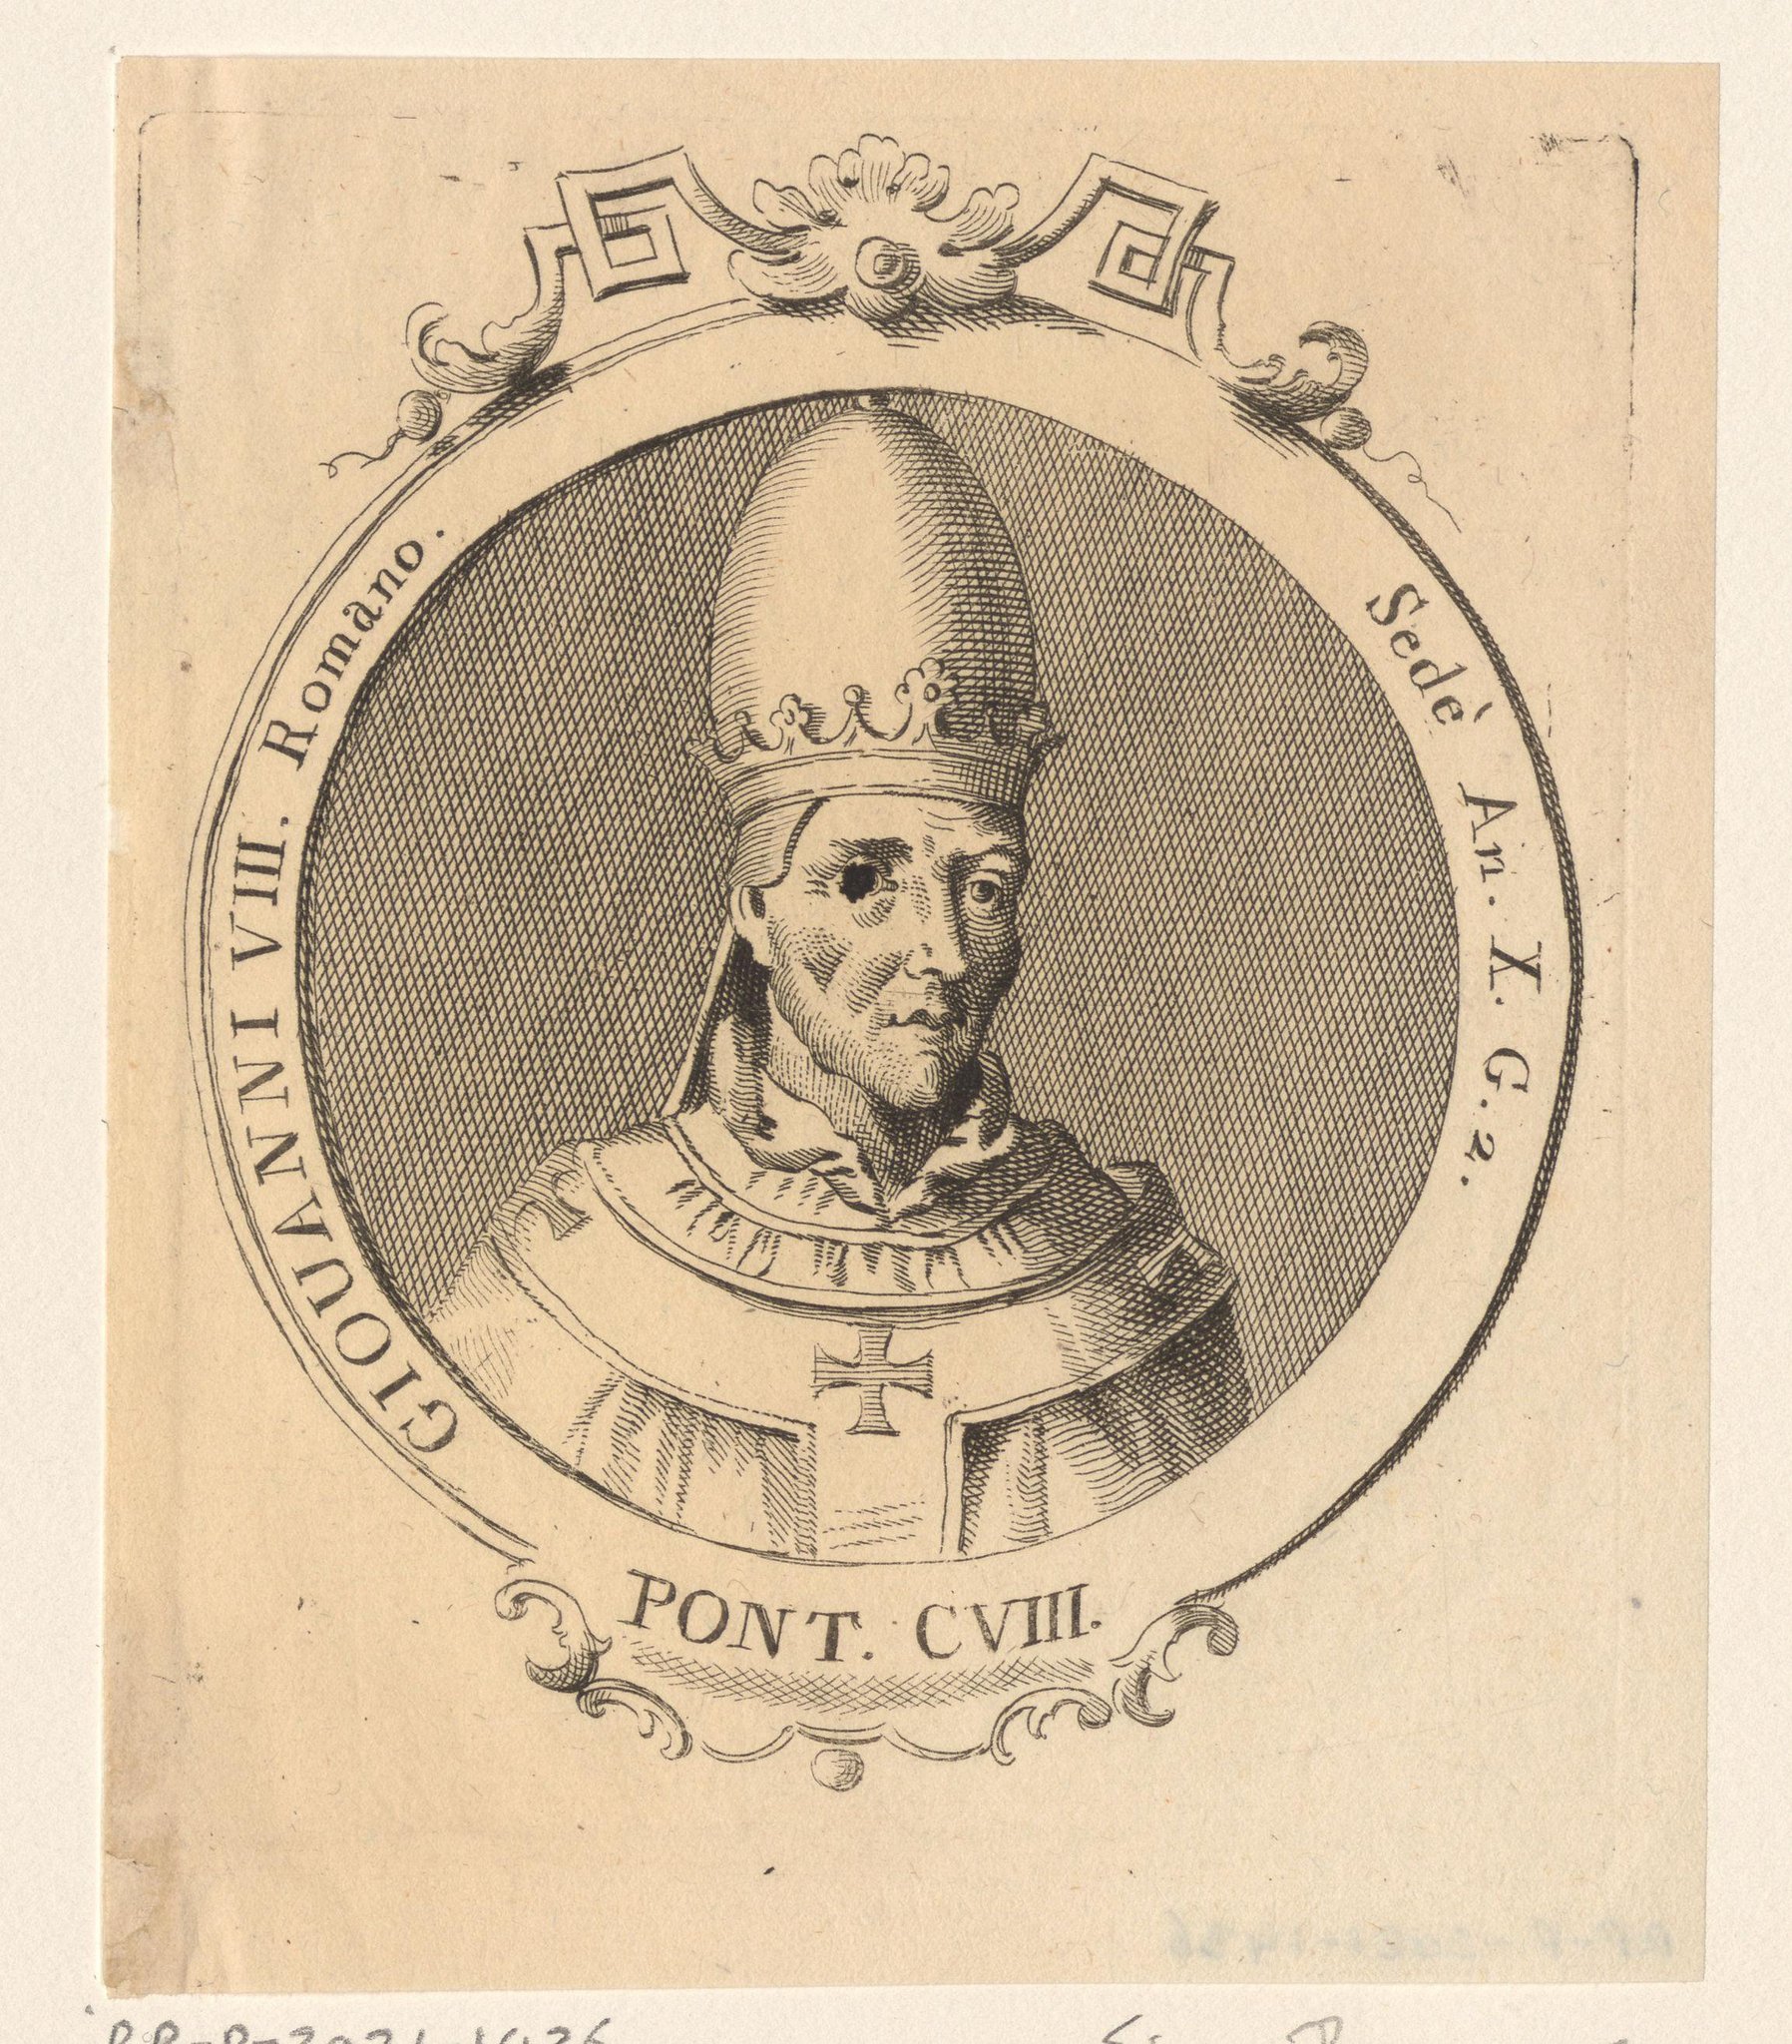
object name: print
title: Portret van paus Johannes VIII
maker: Anonymous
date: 1761-1775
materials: paper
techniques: etching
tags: historical persons, pope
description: Prent waarschijnlijk uit: Effigies Romanorum pontificum a S. Petro ad Pium VI (...). 2 dln. Venetië en Bassano del Grappa: Giuseppe Remondini, 1775. Prent met tekst op verso gebruikt in: Platina (Bartholomaeus Sacchi). Storia delle vite dei pontefici da Platina e d'altri autori (...). Venetië: Domenico Ferrarin, 1760, dl. 2, p. 91.